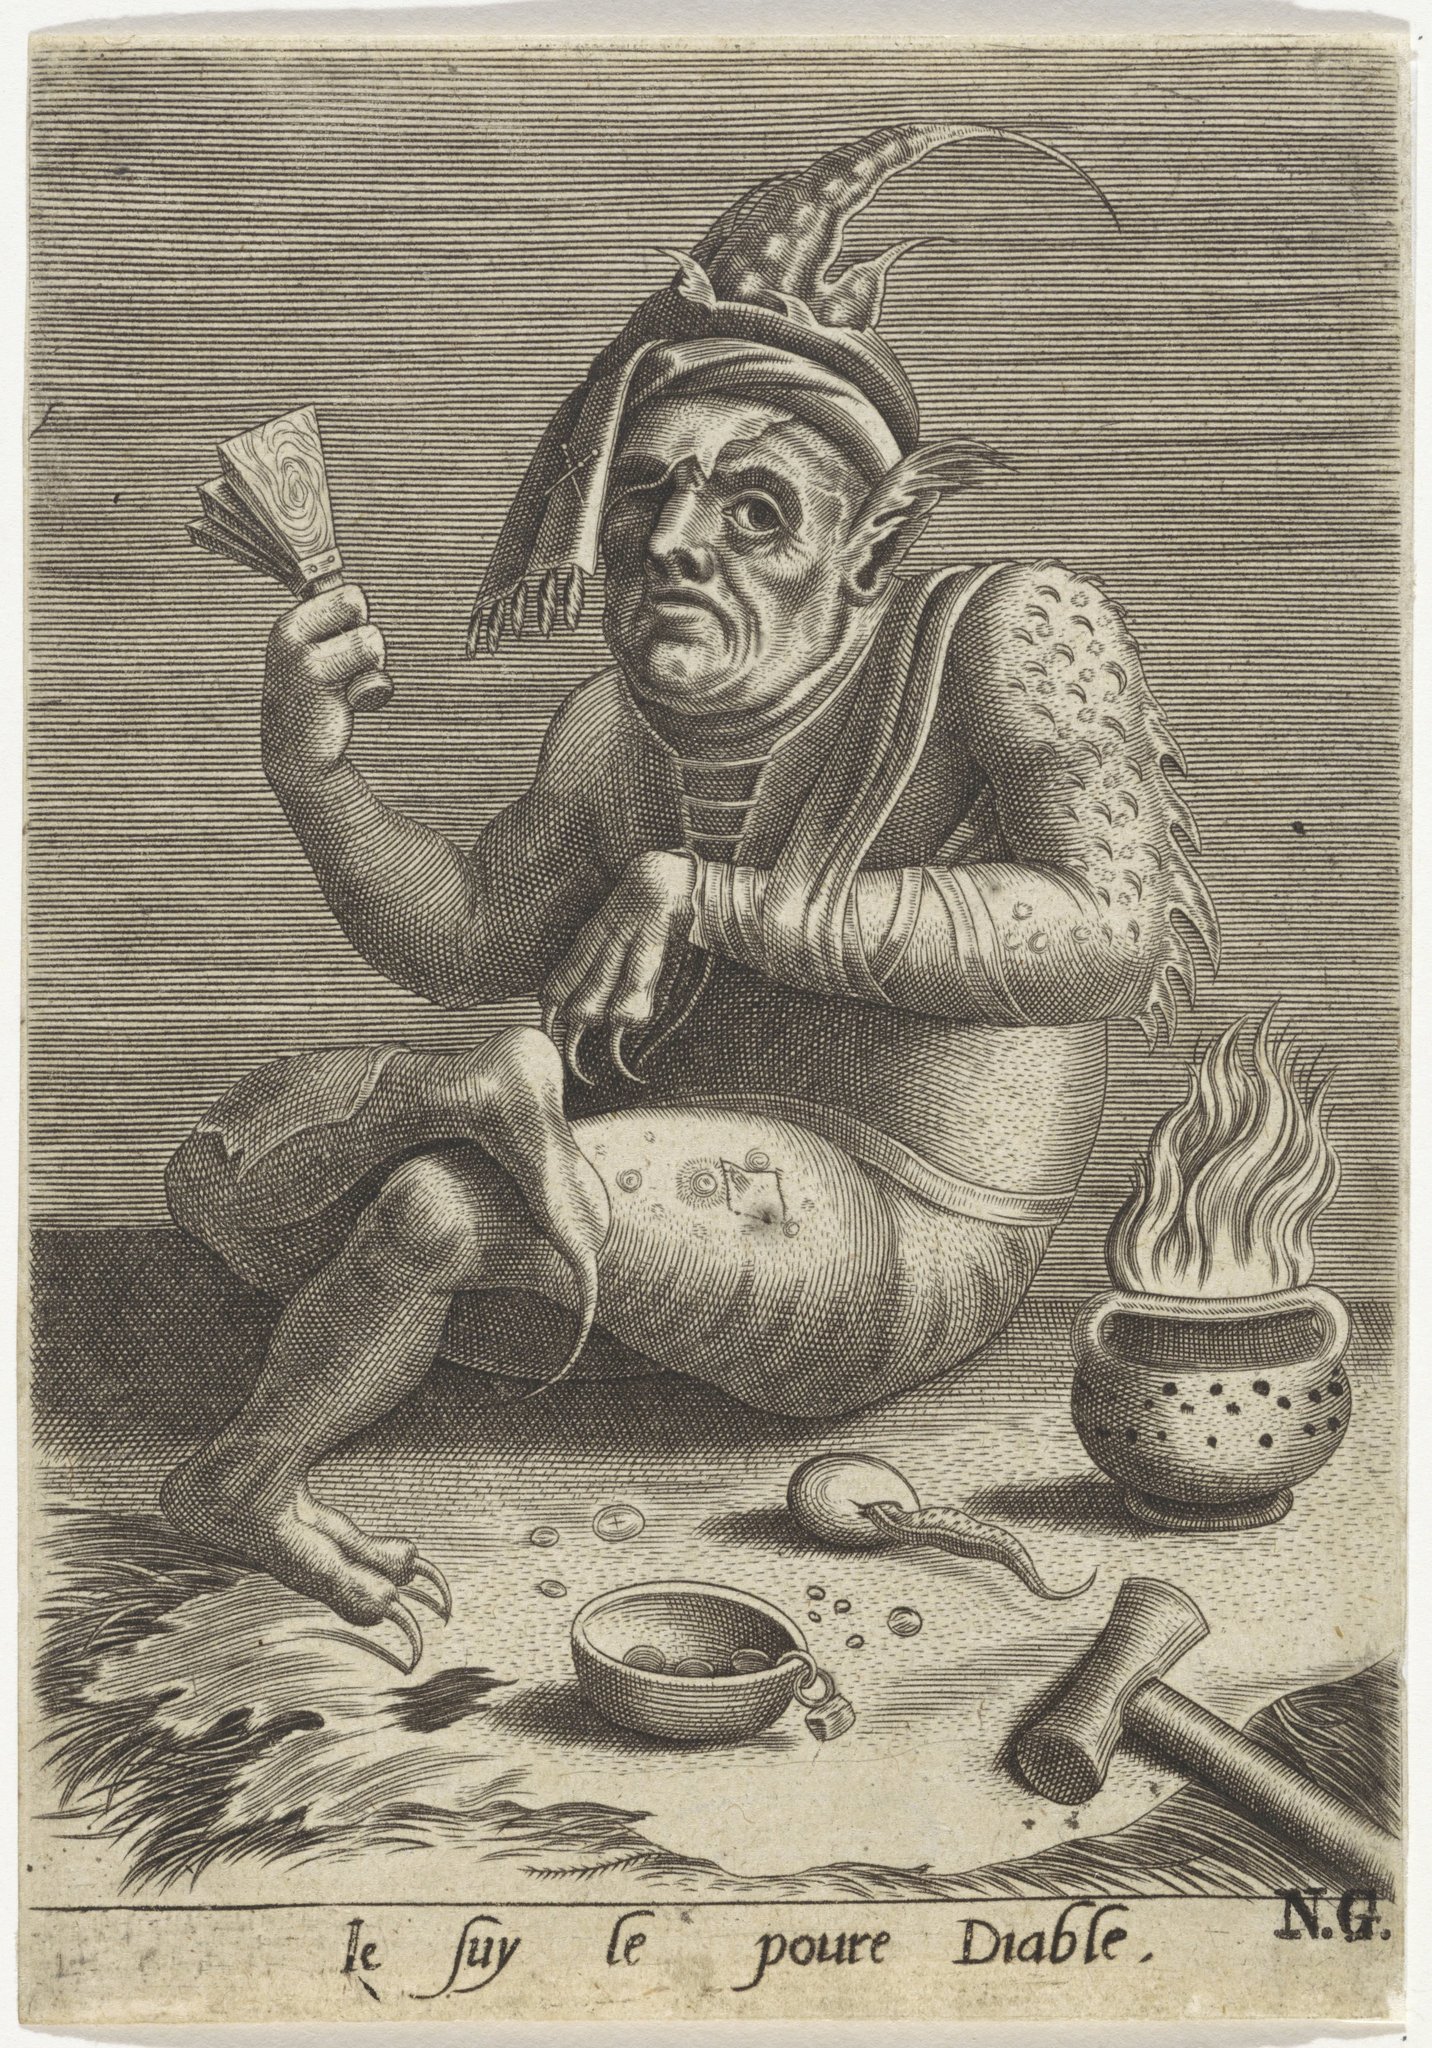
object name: print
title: Leprozenbedelaar in de gedaante van de Duivel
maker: Anonymous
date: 1474-1566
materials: paper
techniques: engraving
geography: netherlands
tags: leper's rattle, devil(s) and demons, beggar, leprosy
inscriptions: collector's mark: Lugt 1967, collector's mark: Lugt 2228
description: De leprozenbedelaar is als de Duivel met klauwen afgebeeld. Hij beschikt over zijn attributen: de klepper, bedelnap met geldstukken, pelgrimsstaf en het vormseldoek met het pelgrimsteken van Santiago de Compostella. Voor de figuur kruipt een adder uit een ei (addergebroed) en naast hem een brandende vuurtest. Zijn huid vertoont een schubachtige uitslag met puisten en etterende wonden. Zijn linkerarm rust in een draagdoek.